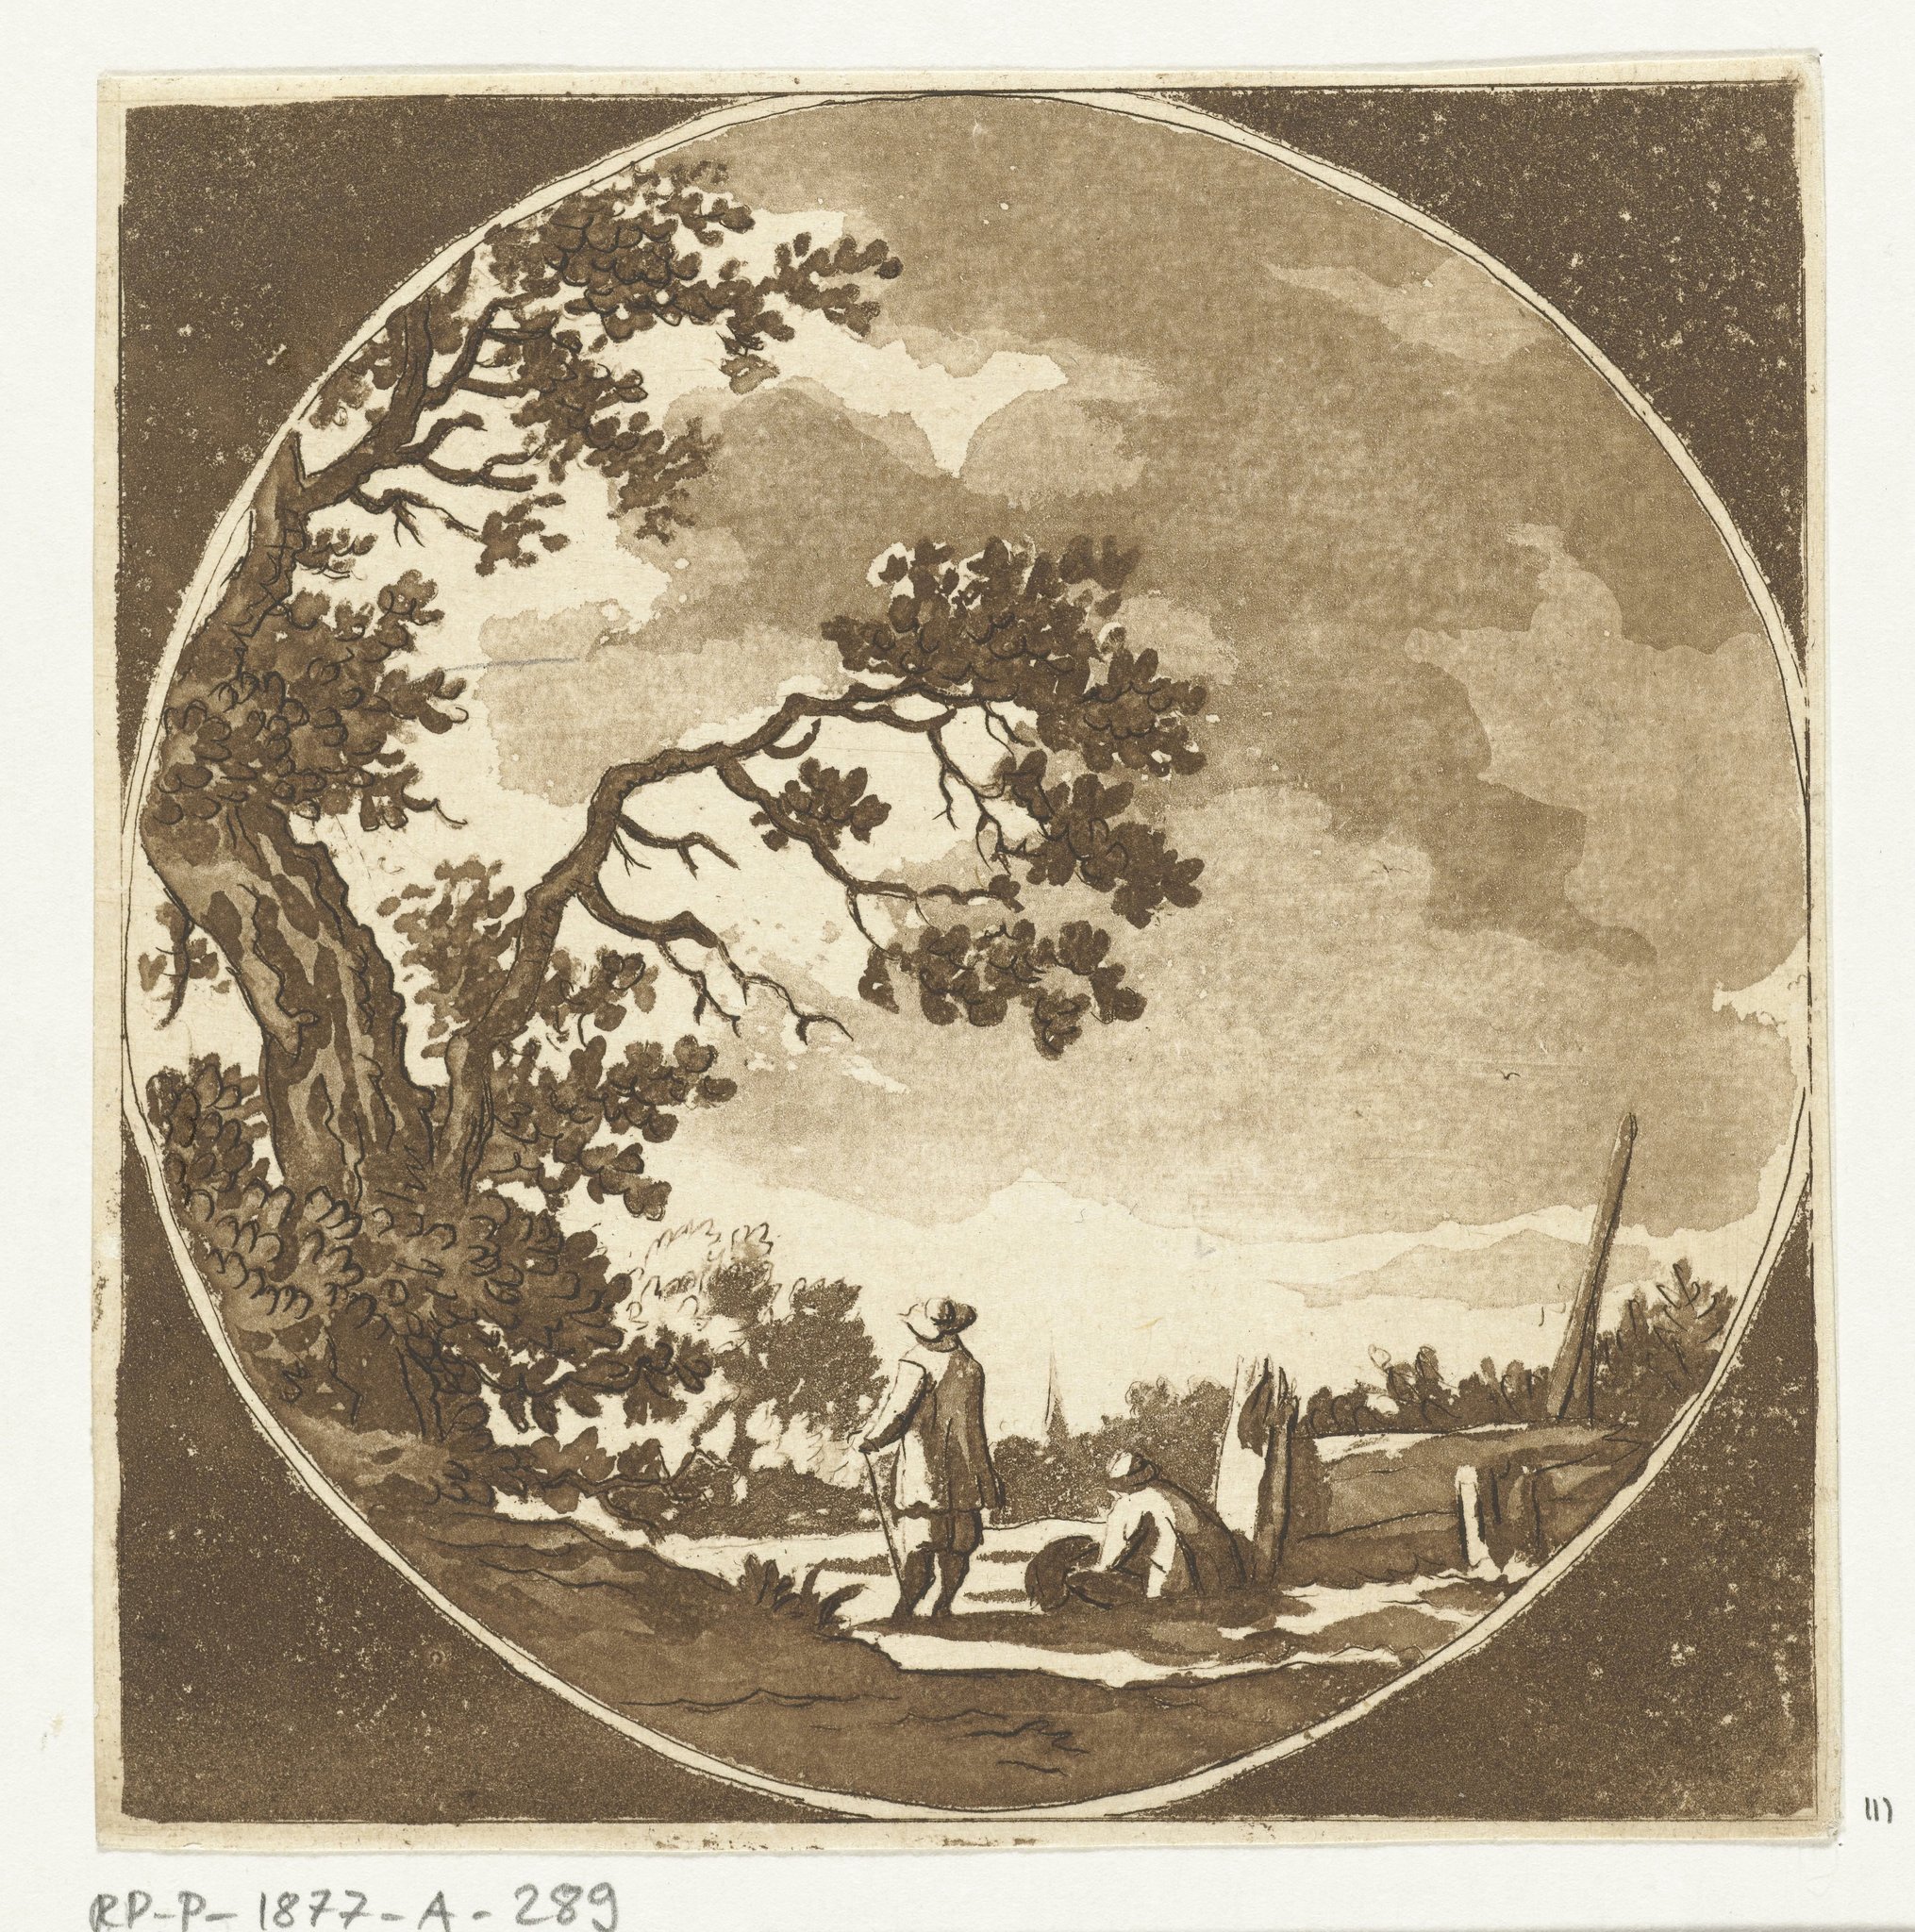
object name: print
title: Landschap met twee wandelaars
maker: anthonie van den bos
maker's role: draughtsman, print maker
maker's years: 1763-1838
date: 1778-1838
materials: paper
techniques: aquatint, etching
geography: netherlands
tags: landscapes in the temperate zone (+ landscape with figures, staffage)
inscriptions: collector's mark: Lugt 2228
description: Twee wandelaars kijken uit over een weiland naar een dorp in de verte. De een staat op zijn stok geleund de ander zit op de grond.